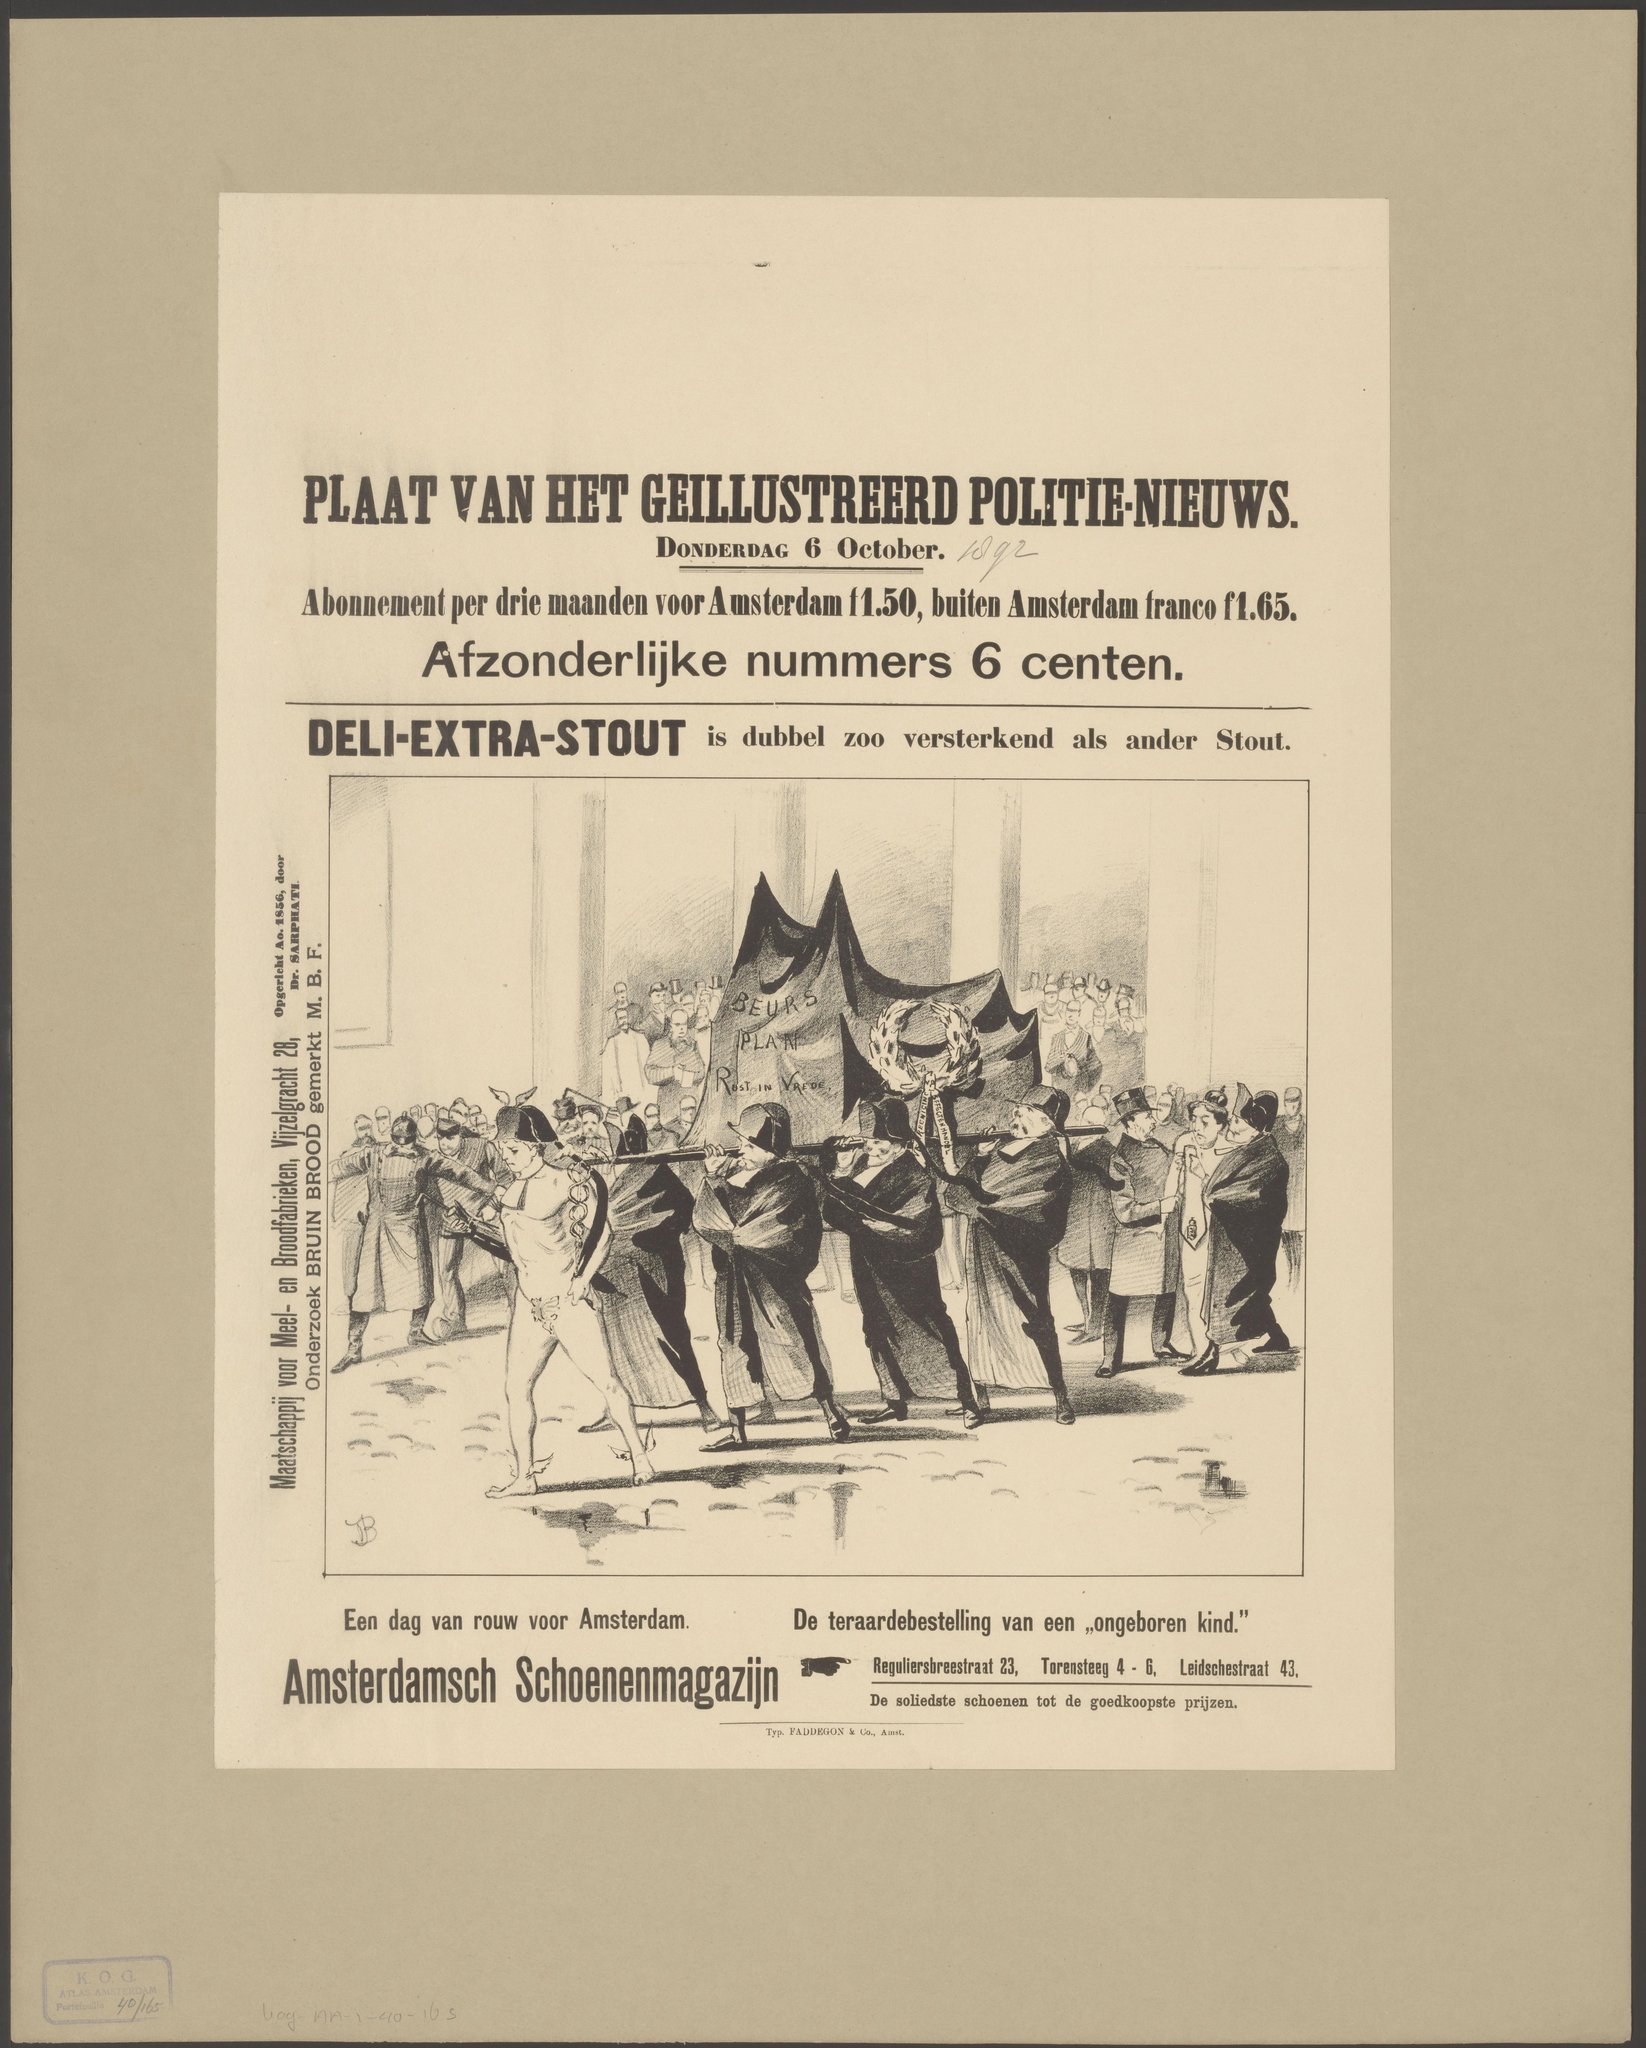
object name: print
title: Een dag van rouw voor Amsterdam. De teraardbestelling van een "ongeboren kind"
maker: johan braakensiek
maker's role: draughtsman, print maker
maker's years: 1858-1940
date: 1892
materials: paper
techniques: letterpress printing, lithograph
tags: stock exchange, stock-market, funerary ceremonial, specific aspects, allegorical aspects of mercury; mercury as patron, amsterdam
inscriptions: collector's mark: Lugt 1641b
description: Onderwerpsrubriek binnen de Atlas Amsterdam: Handel en Zeevaart, E. Spotprenten betreffende de Beurs.